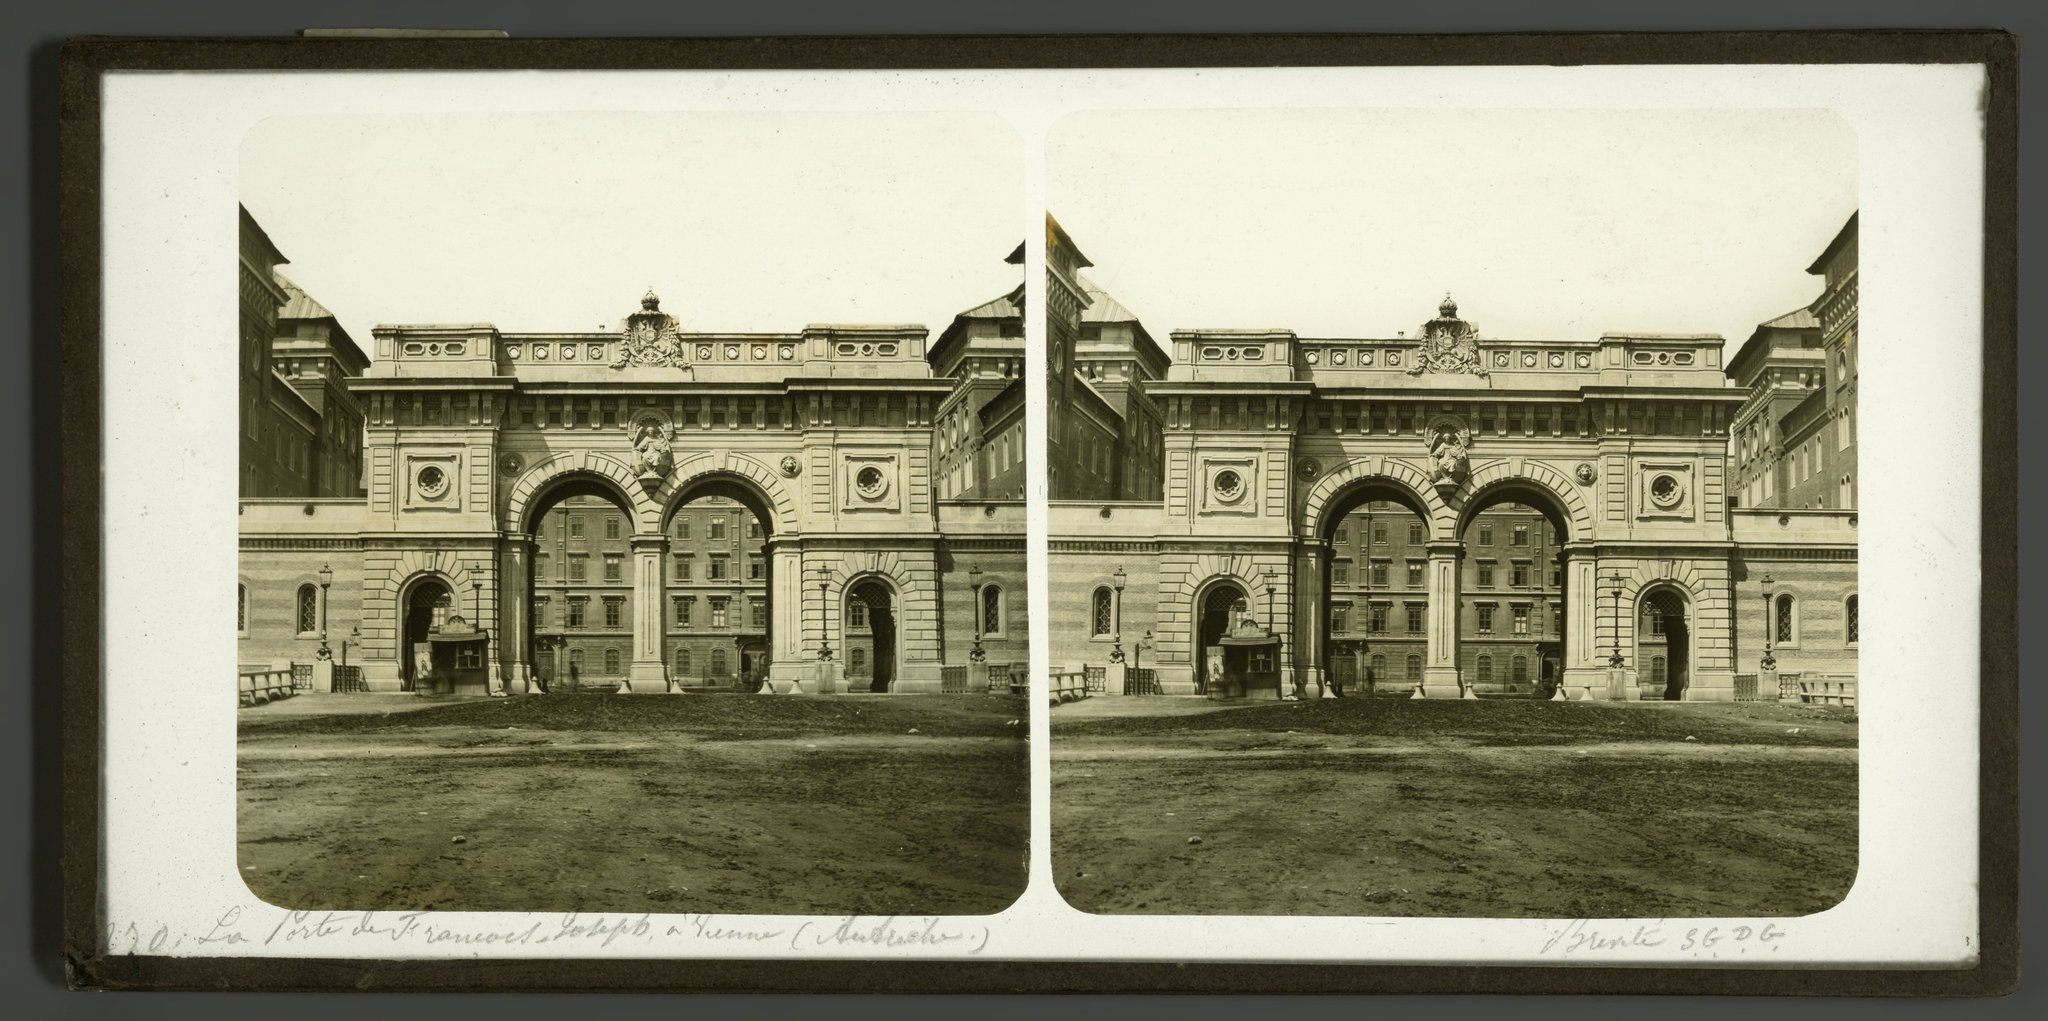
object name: stereoscopic photograph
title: Gezicht op een stadspoort in Wenen, Oostenrijk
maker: Anonymous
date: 1856-1890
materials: glass, paper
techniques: slide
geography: vienna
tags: city-gate, vienna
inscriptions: annotation: ‘270. La Porte de Francois-Joseph, à Vienne (Autriche.) Breveté S.G.D.G.’